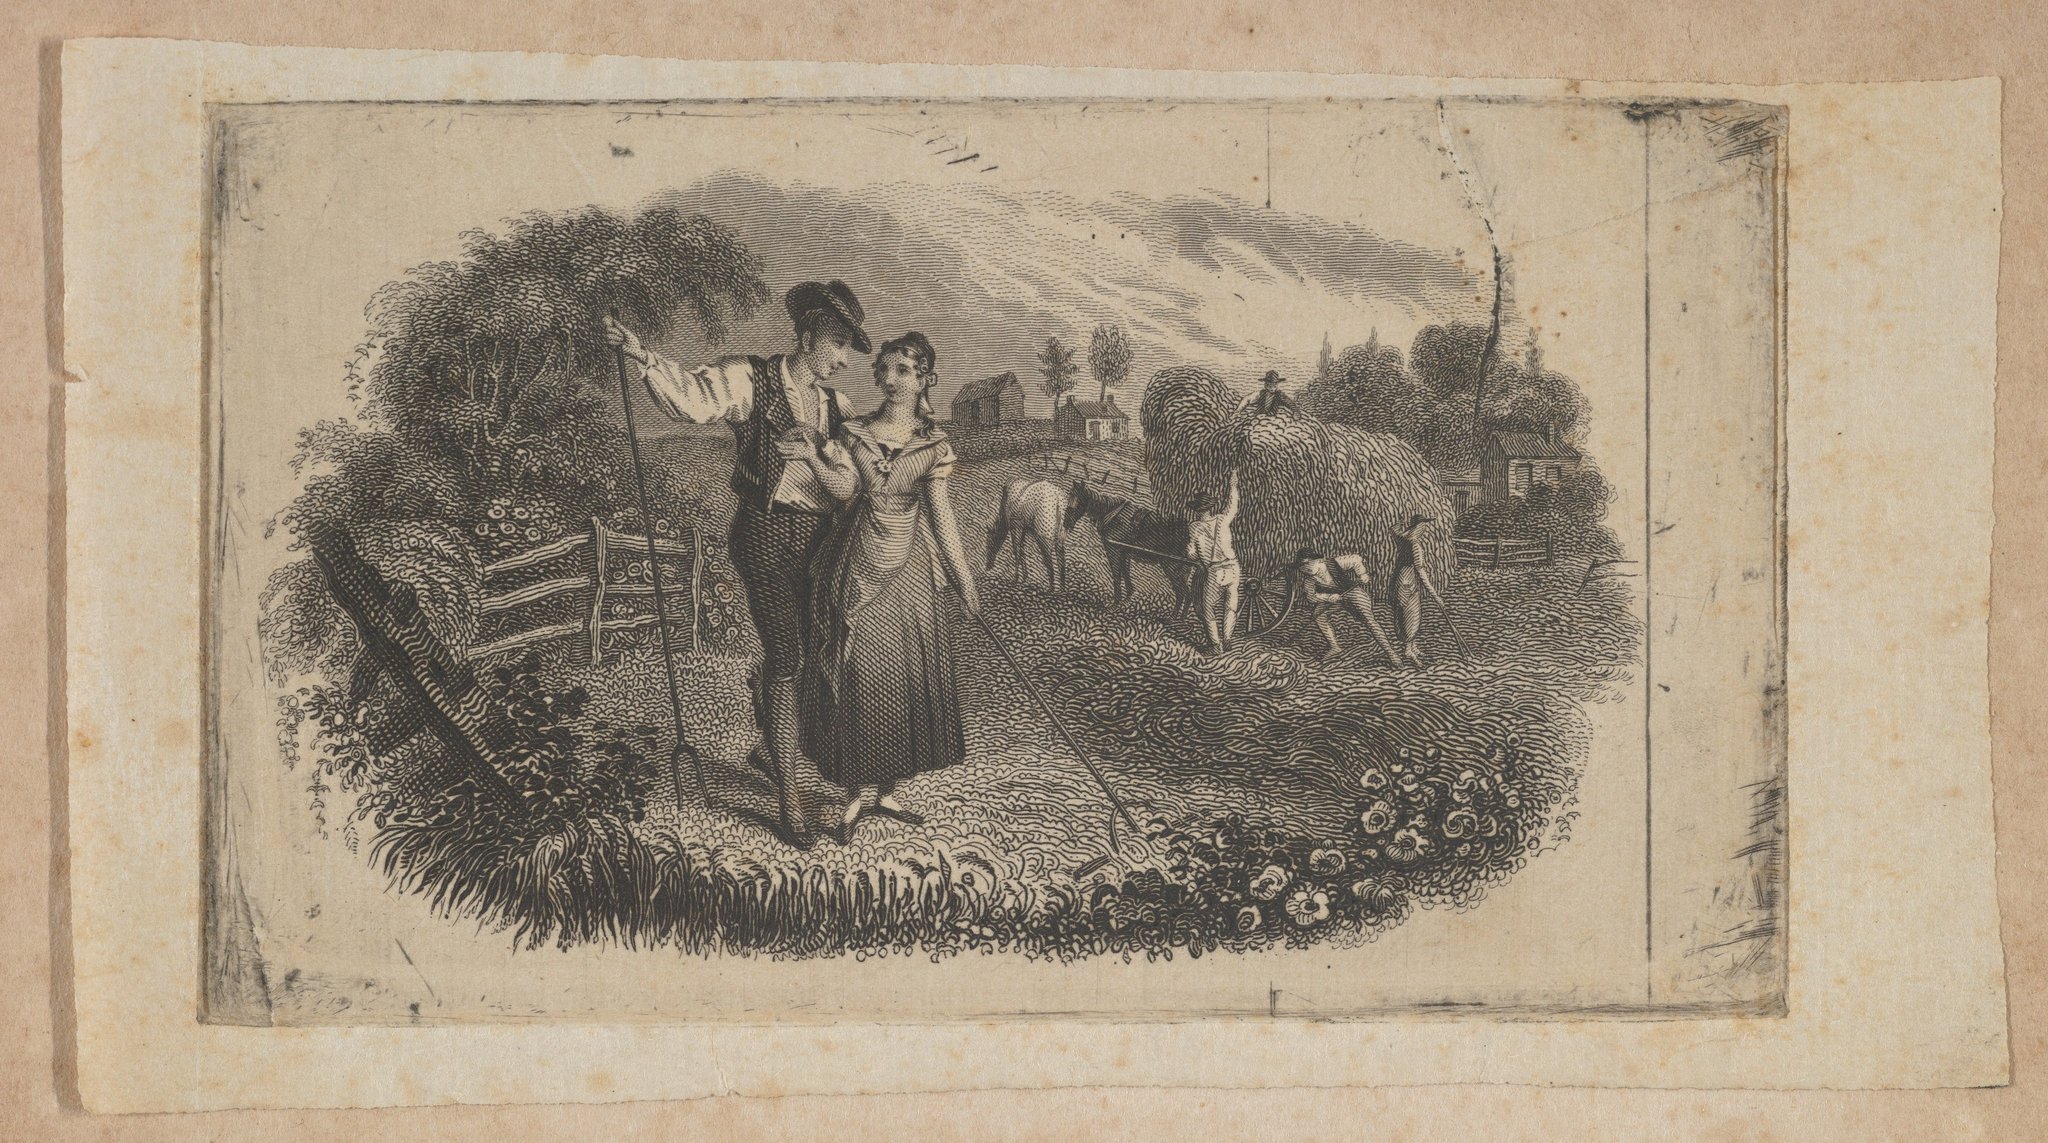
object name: print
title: Banknote vignette with haymakers symbolizing rural industry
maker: asher brown durand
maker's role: artist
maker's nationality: american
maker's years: 1796-1886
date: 1824-1837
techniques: printmaking, engraving, etching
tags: animals,houses,men,women,money